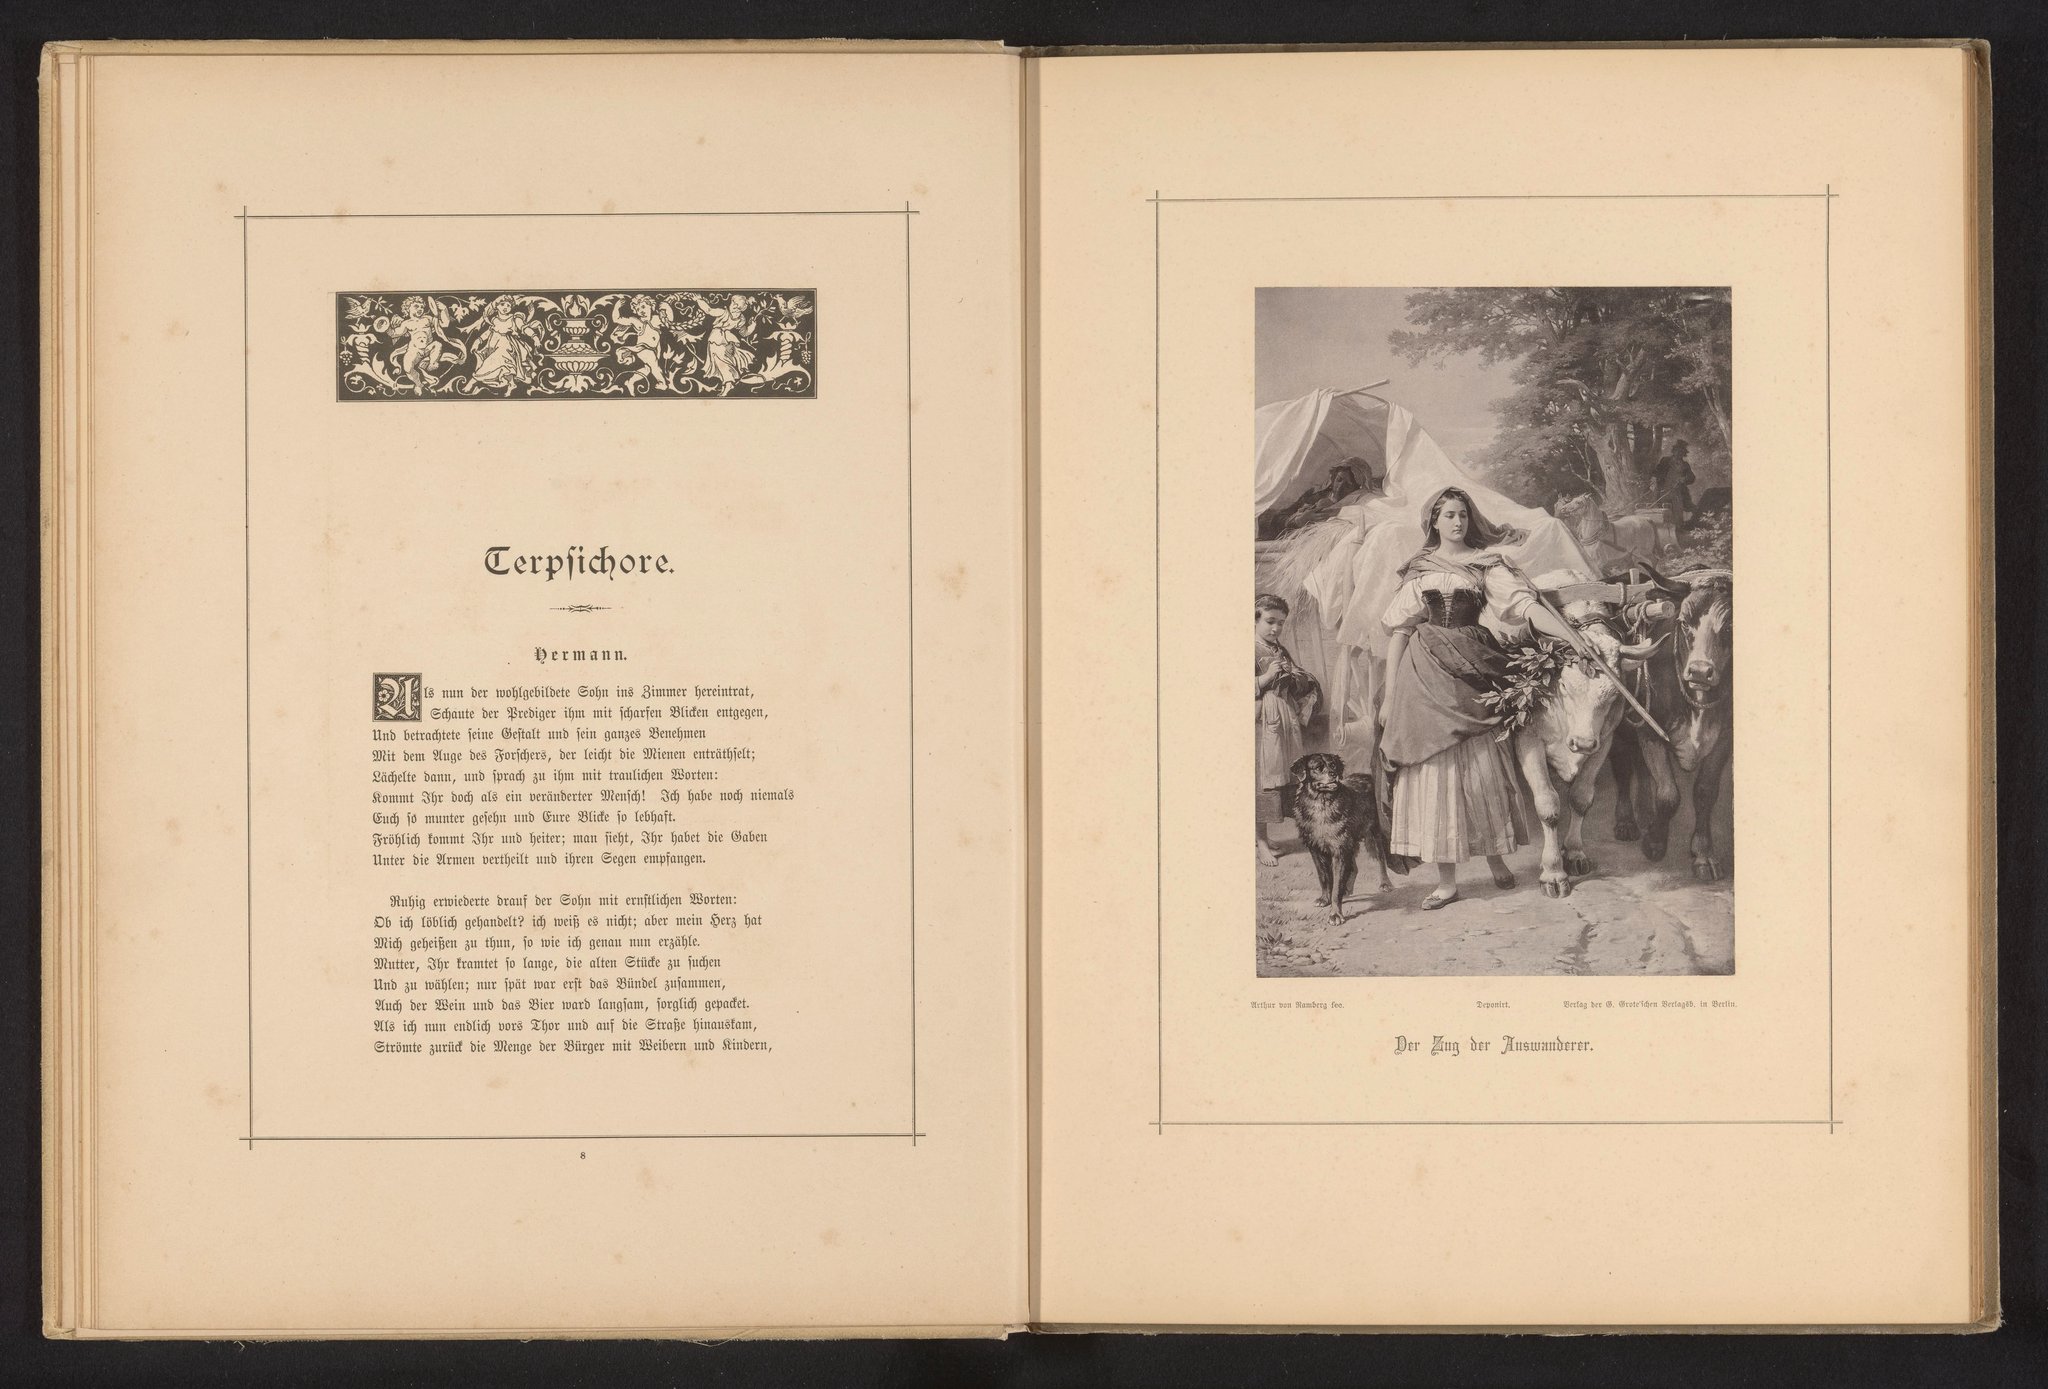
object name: reproduction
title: Der Zug der Auswanderer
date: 1876-1881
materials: paper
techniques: photograph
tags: cow, adult woman, exile (of old government or its adherents)